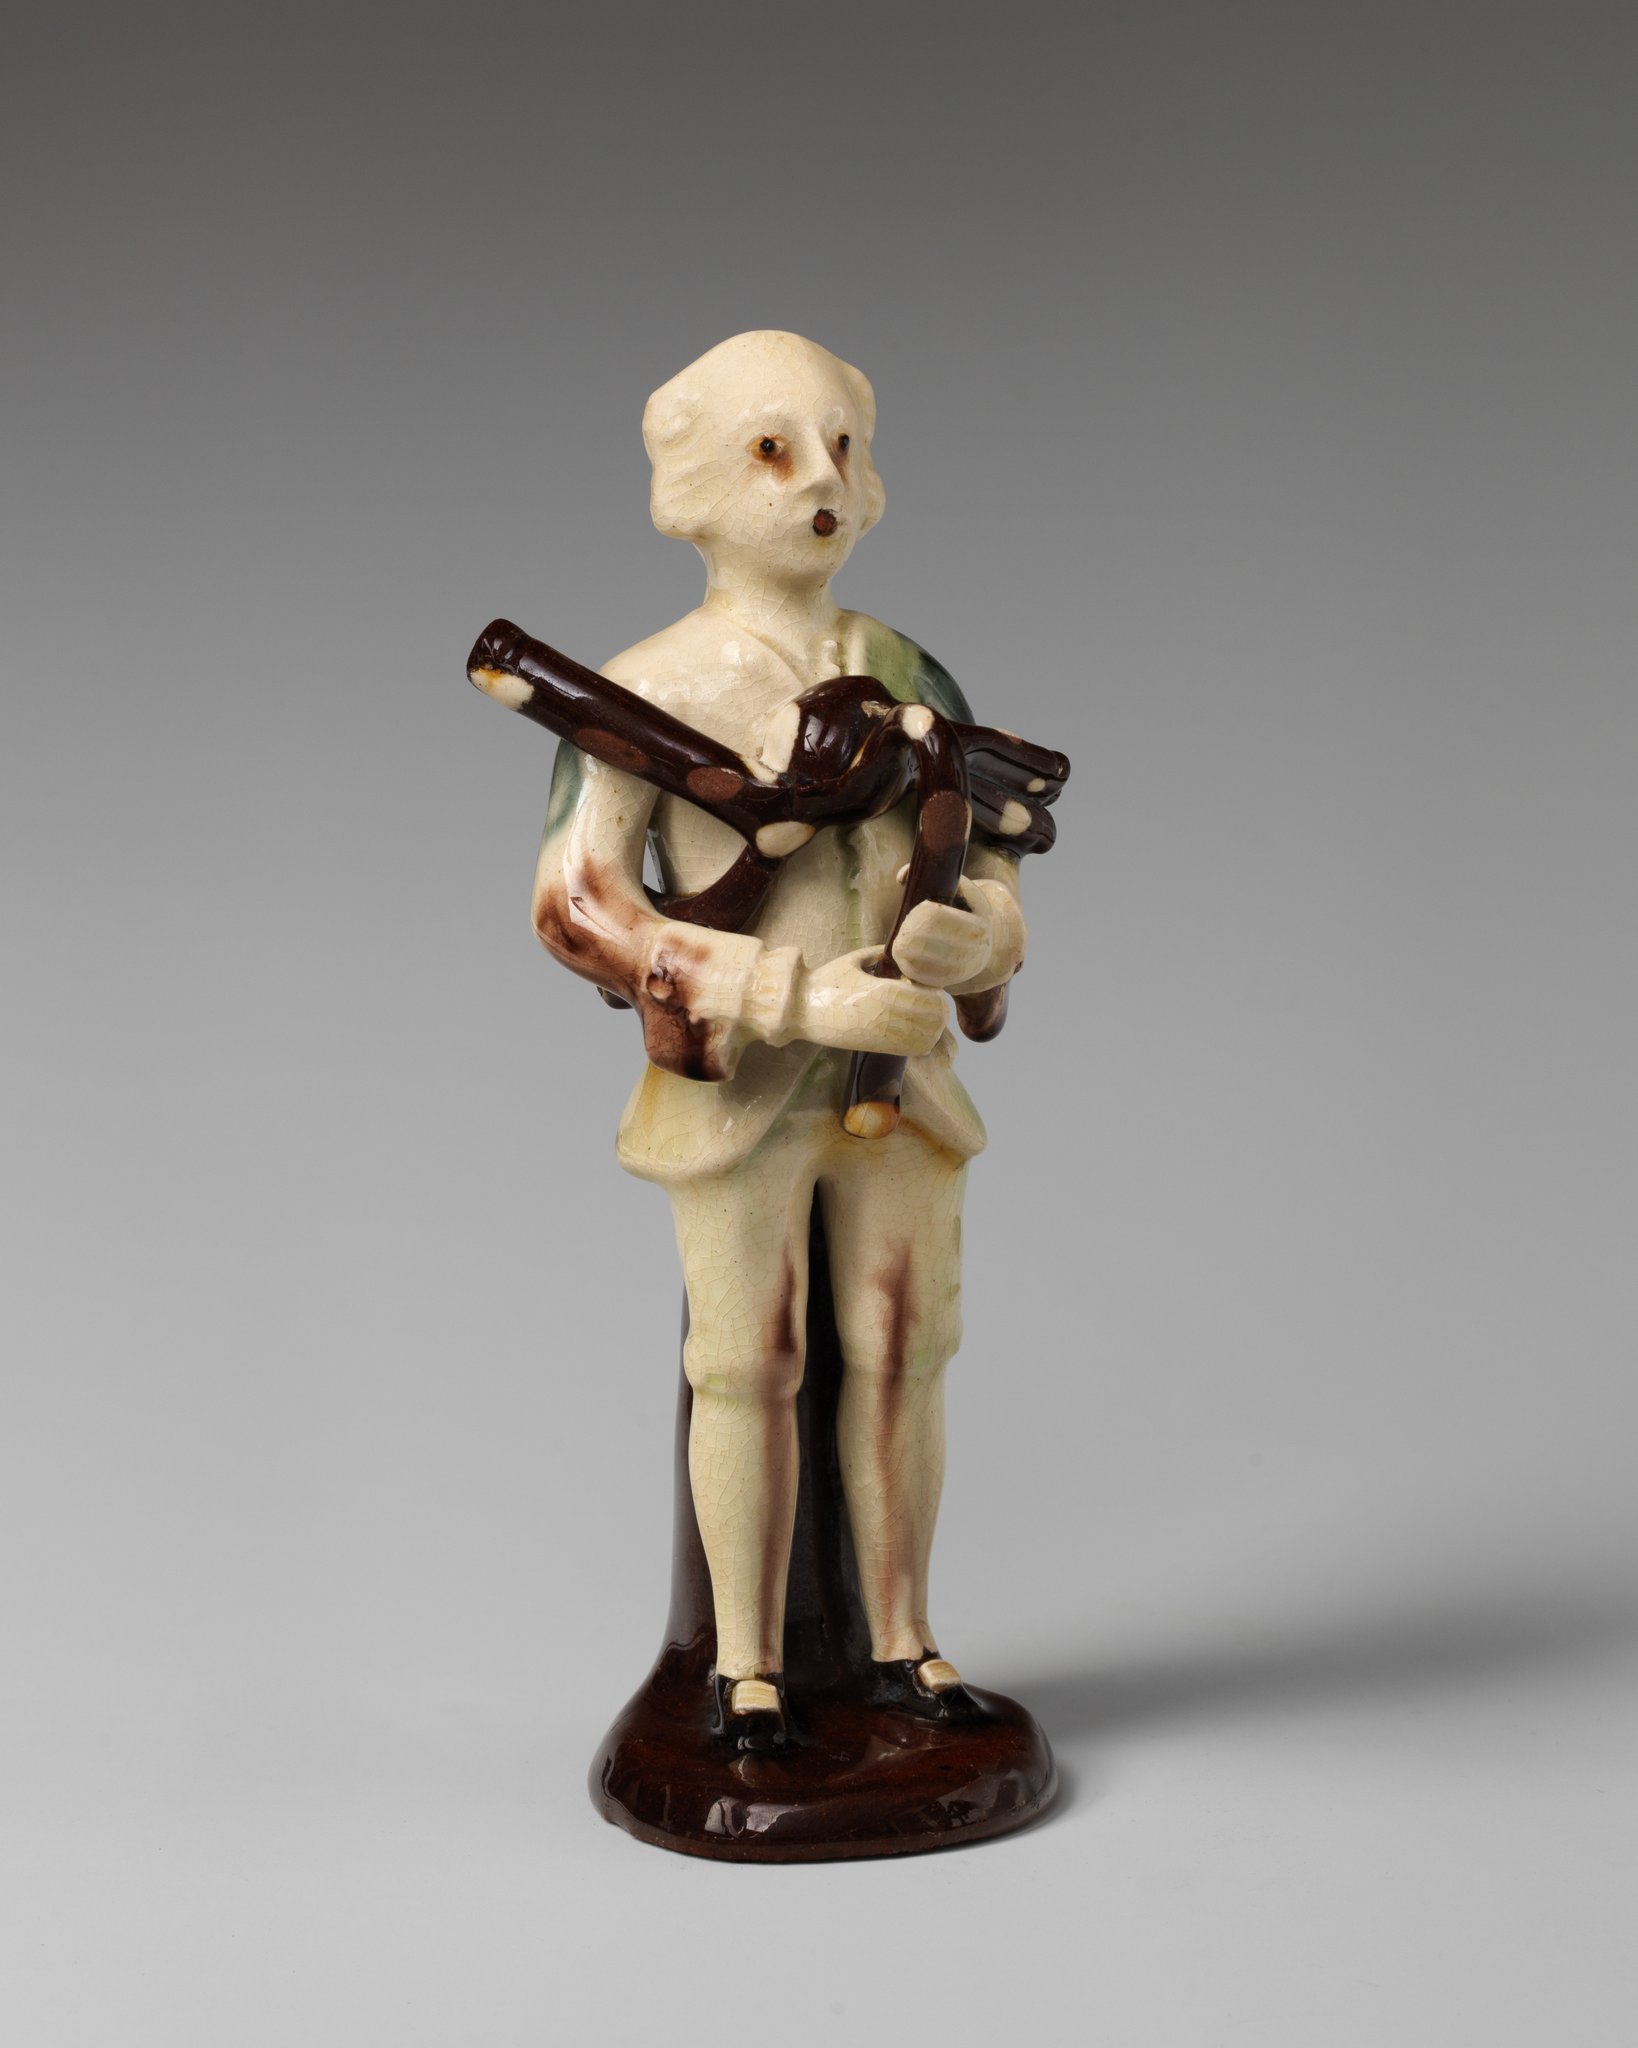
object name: figure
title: Bagpiper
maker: whieldon type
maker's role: maker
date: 1760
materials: earthenware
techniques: glazing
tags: men,bagpipes